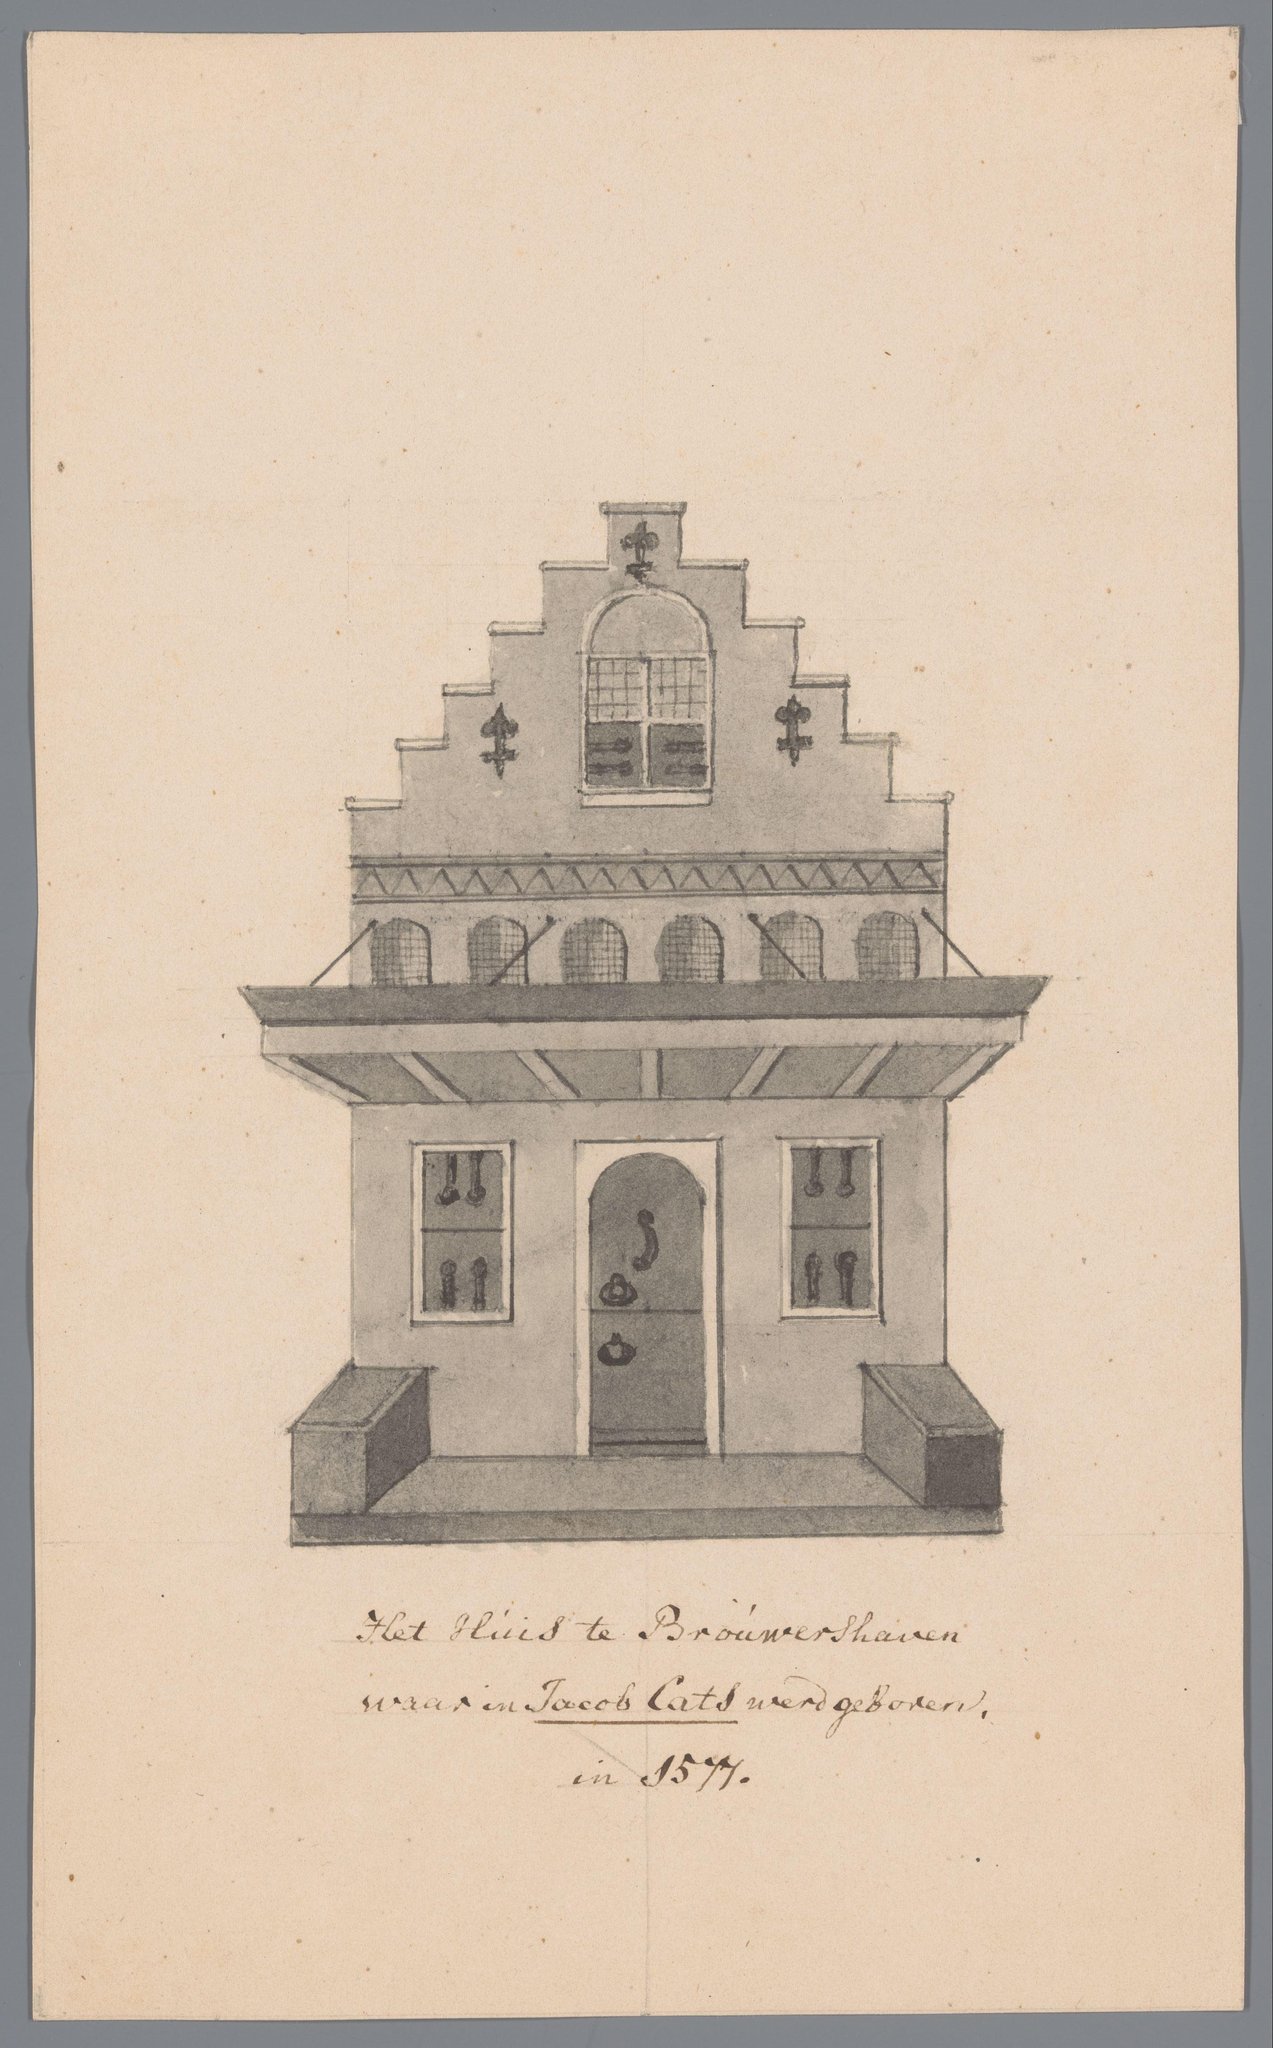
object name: drawing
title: Het Huis te Brouwershaven waar in Jacob Cats werd geboren in 1577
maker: Anonymous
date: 1750-1849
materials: ink, paper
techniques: brush, pen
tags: façade (of house or building)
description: Deze tekening is waarschijnlijk vervaardigd naar een prent, zie bijvoorbeeld RP-P-2019-1501.